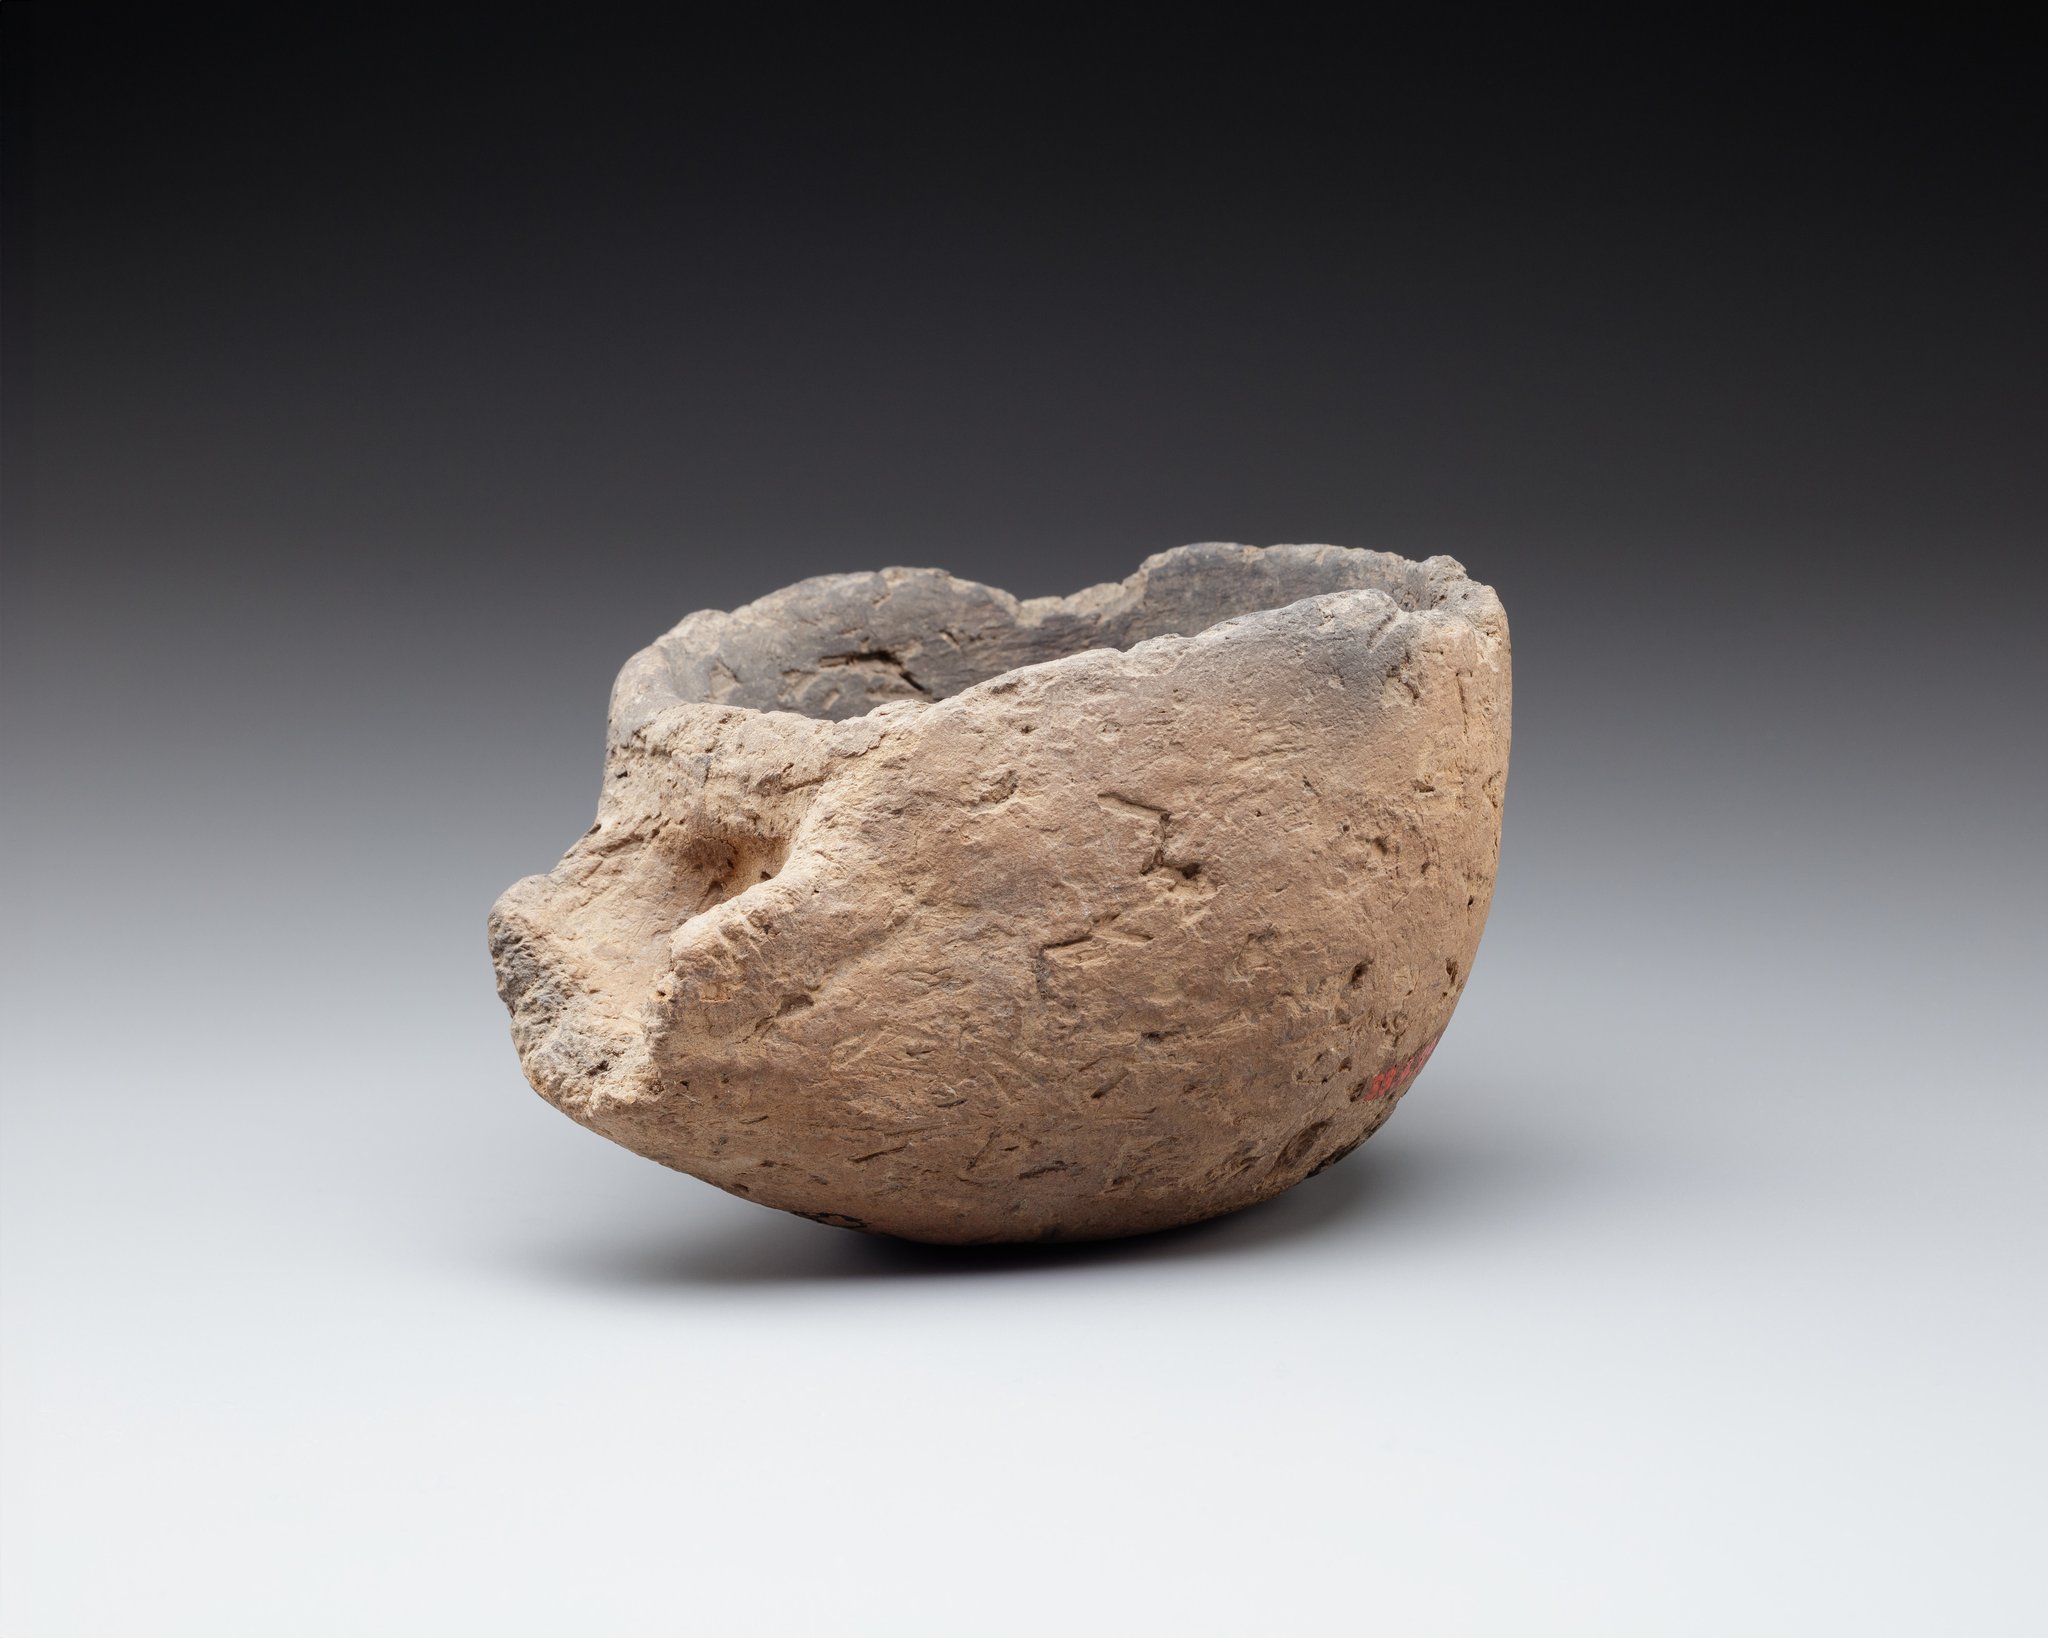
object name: ladle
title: Spouted bowl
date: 4500-4000 BCE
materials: pottery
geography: egypt